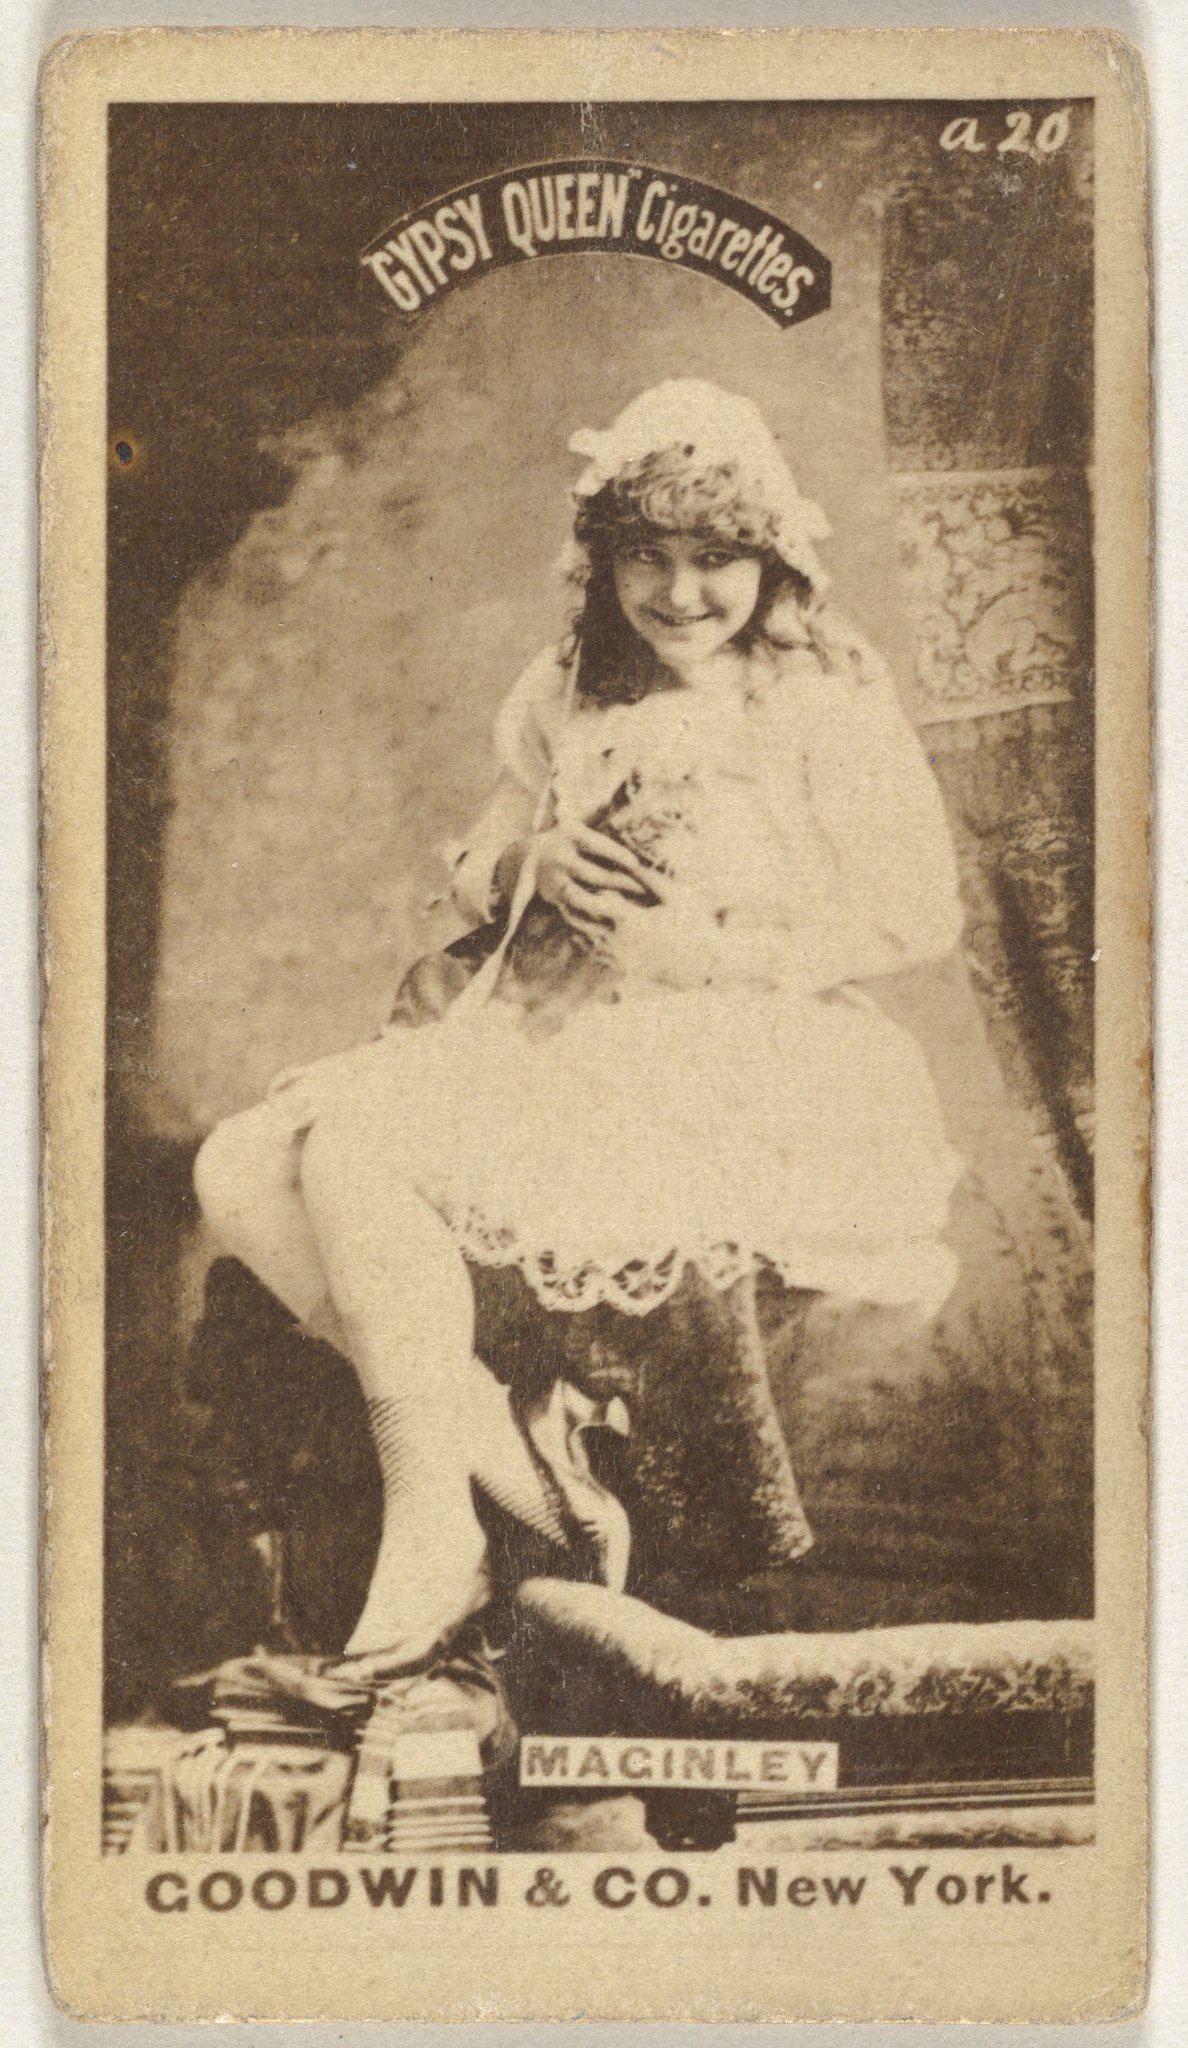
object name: photograph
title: Maginley, from the Actors and Actresses series (N171) for Gypsy Queen Cigarettes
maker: goodwin & company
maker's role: publisher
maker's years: 1850-1950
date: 1886-1890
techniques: albumen silver print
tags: portraits,women,actresses